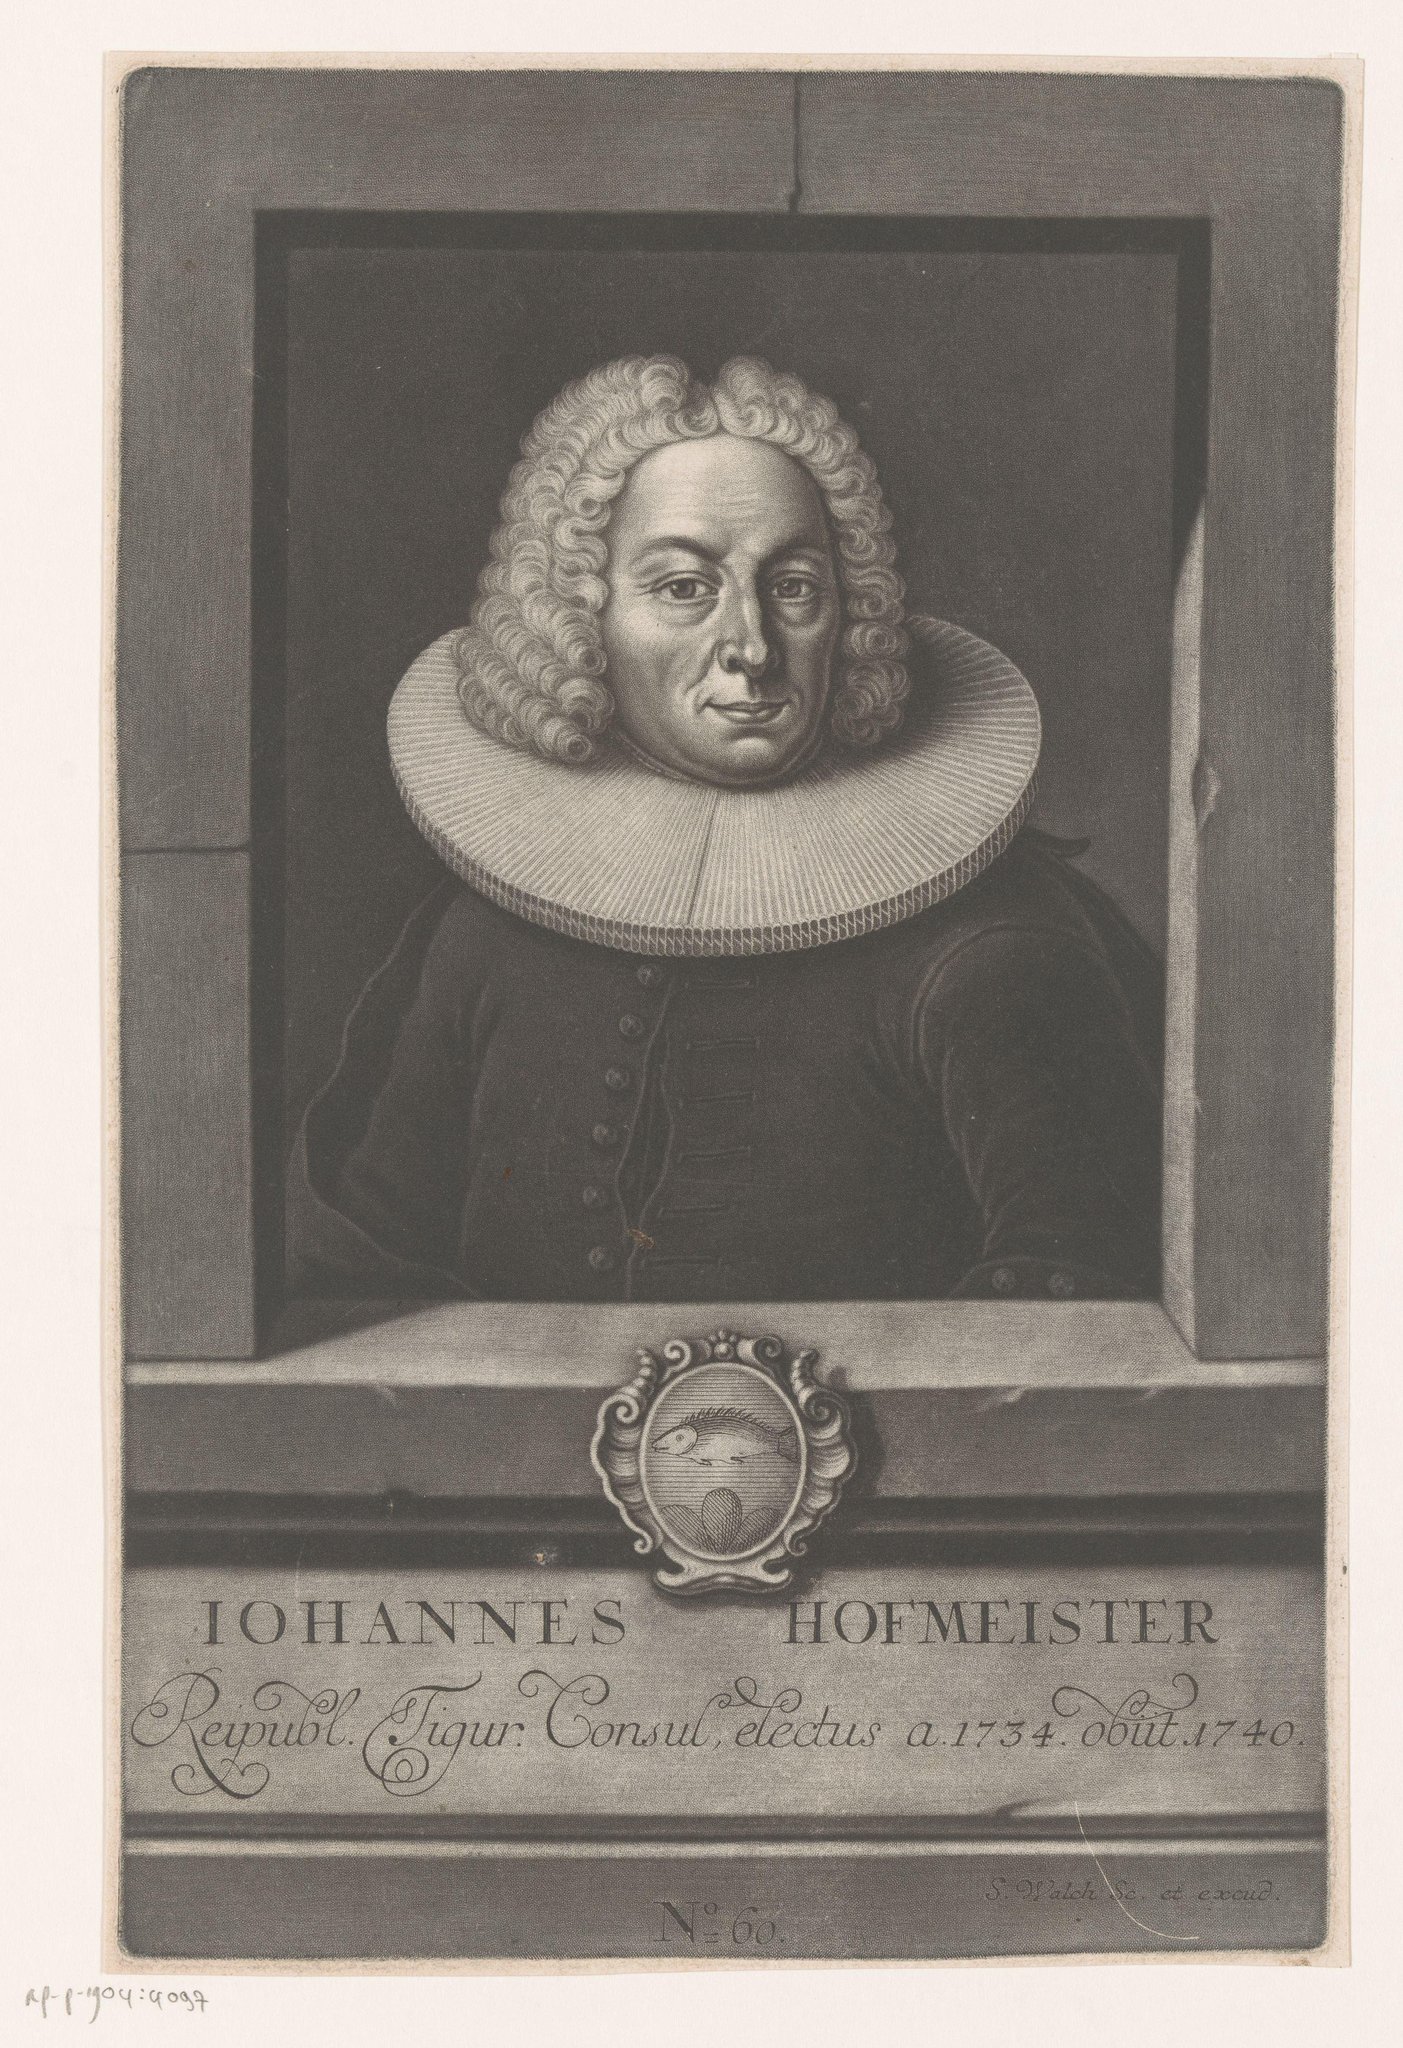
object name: print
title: Portret van Johann Hofmeister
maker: sebastian walch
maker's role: print maker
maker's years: 1721-1788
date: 1740-1788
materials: paper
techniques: mezzotint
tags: mayor, historical persons, armorial bearing, heraldry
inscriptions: collector's mark: Lugt 2228